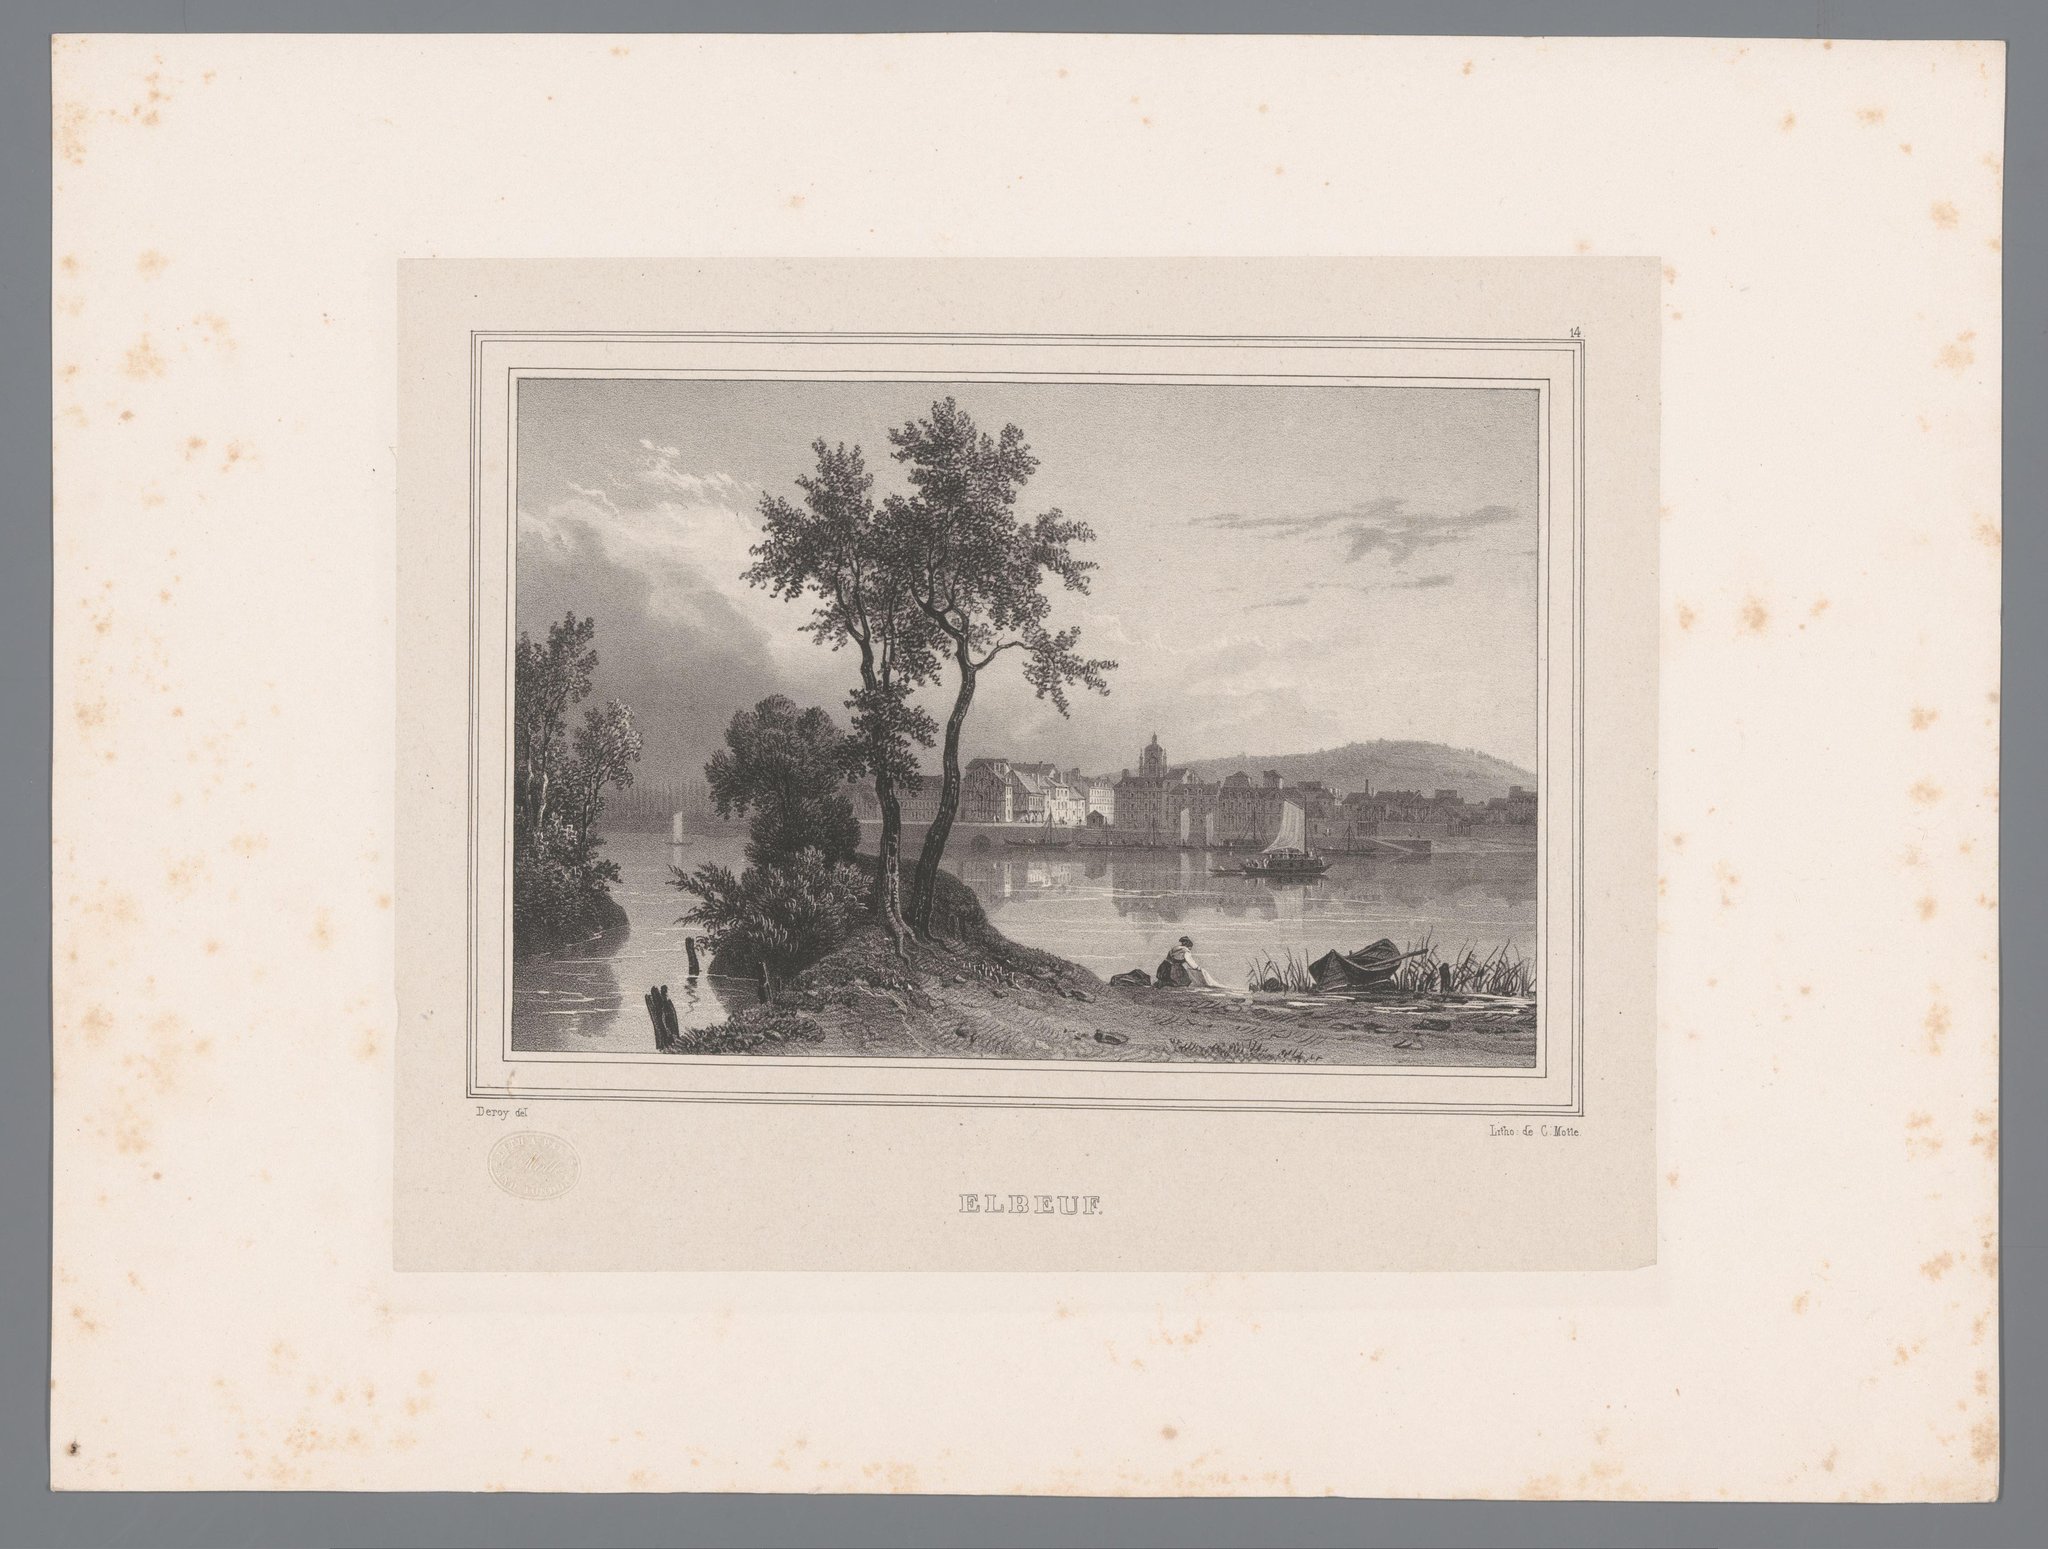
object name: print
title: Gezichten aan de oevers van de Seine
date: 1829-1831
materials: paper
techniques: lithograph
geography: paris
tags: river (+ landscape with figures, staffage), prospect of city, town panorama, silhouette of city (+ city(-scape) with figures, staffage)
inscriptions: collector's mark: Lugt 2228a, check stamp: Lugt 1828b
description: Prent maakt deel uit van een omslag met twaalf prenten.